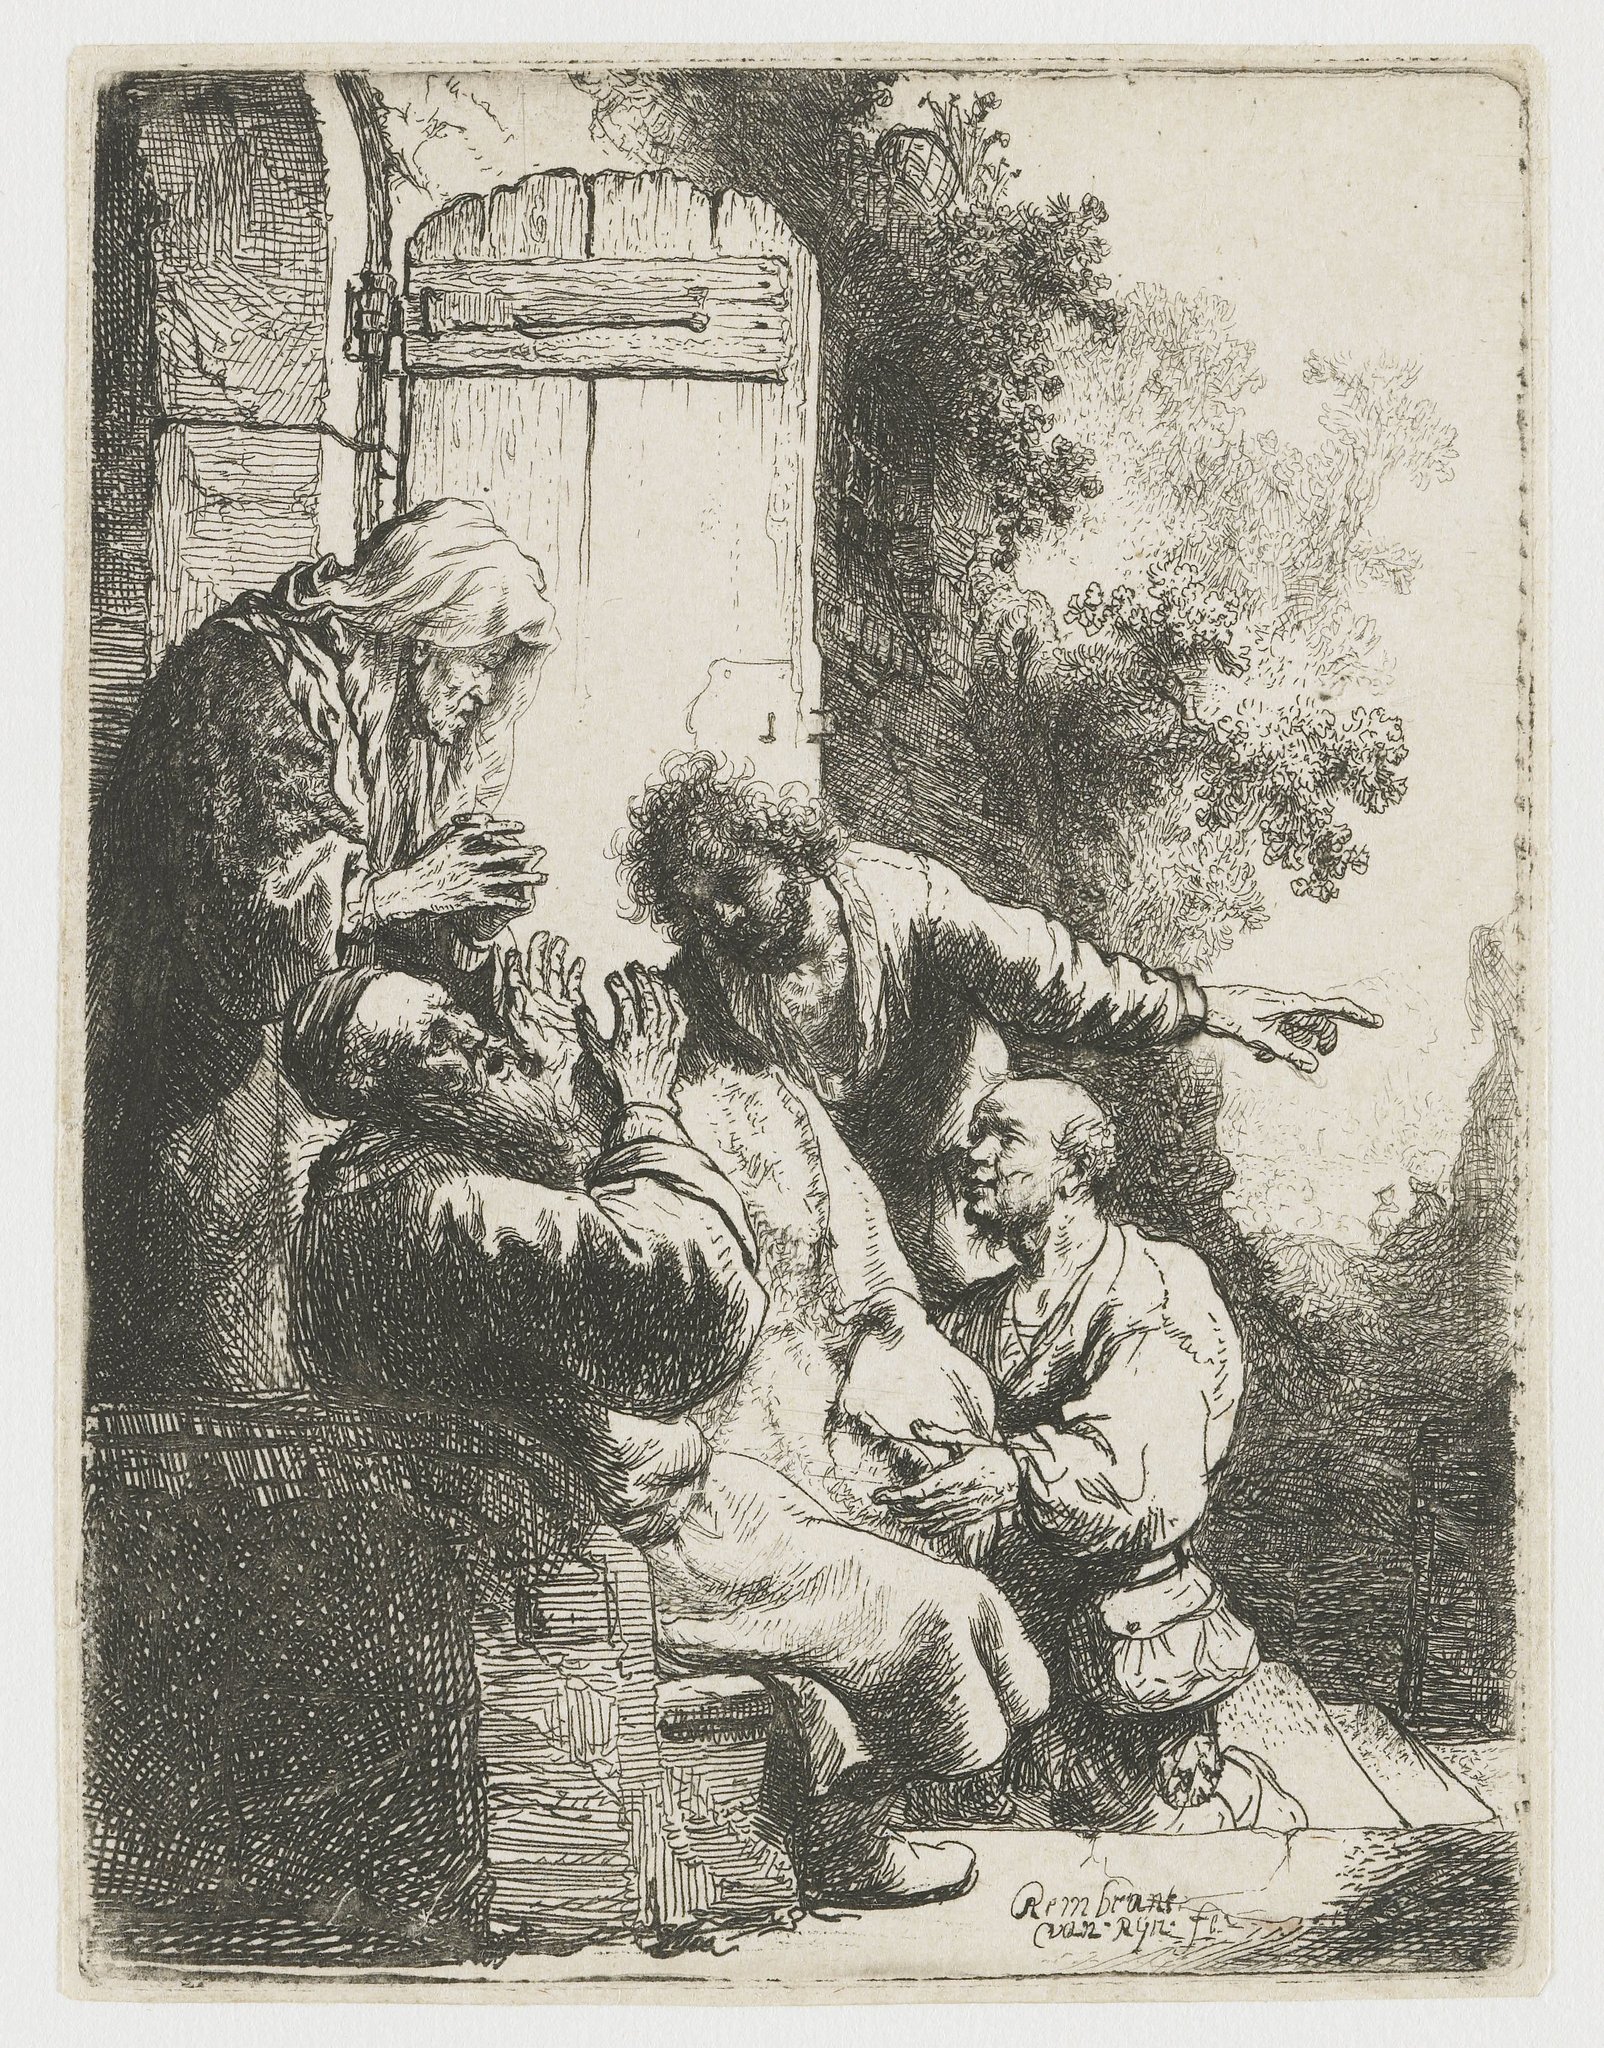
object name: print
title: Joseph's coat brought to Jacob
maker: rembrandt van rijn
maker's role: draughtsman, painter, print maker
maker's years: 1606-1669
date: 1633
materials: paper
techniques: etching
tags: genesis: the story of joseph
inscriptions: signature: ‘Rembrant. van. Ryn. fe’, collector's mark: Lugt 240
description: Joseph’s envious brothers wanted to be rid of him and sold him to merchants on their way to Egypt. They smeared his coat with goat’s blood and showed it to their father, Jacob. He recognized the coat and so believed that Joseph had been devoured by a wild animal. Rembrandt portrays Jacob’s anguish, while the sons point to the place where they found the garment.